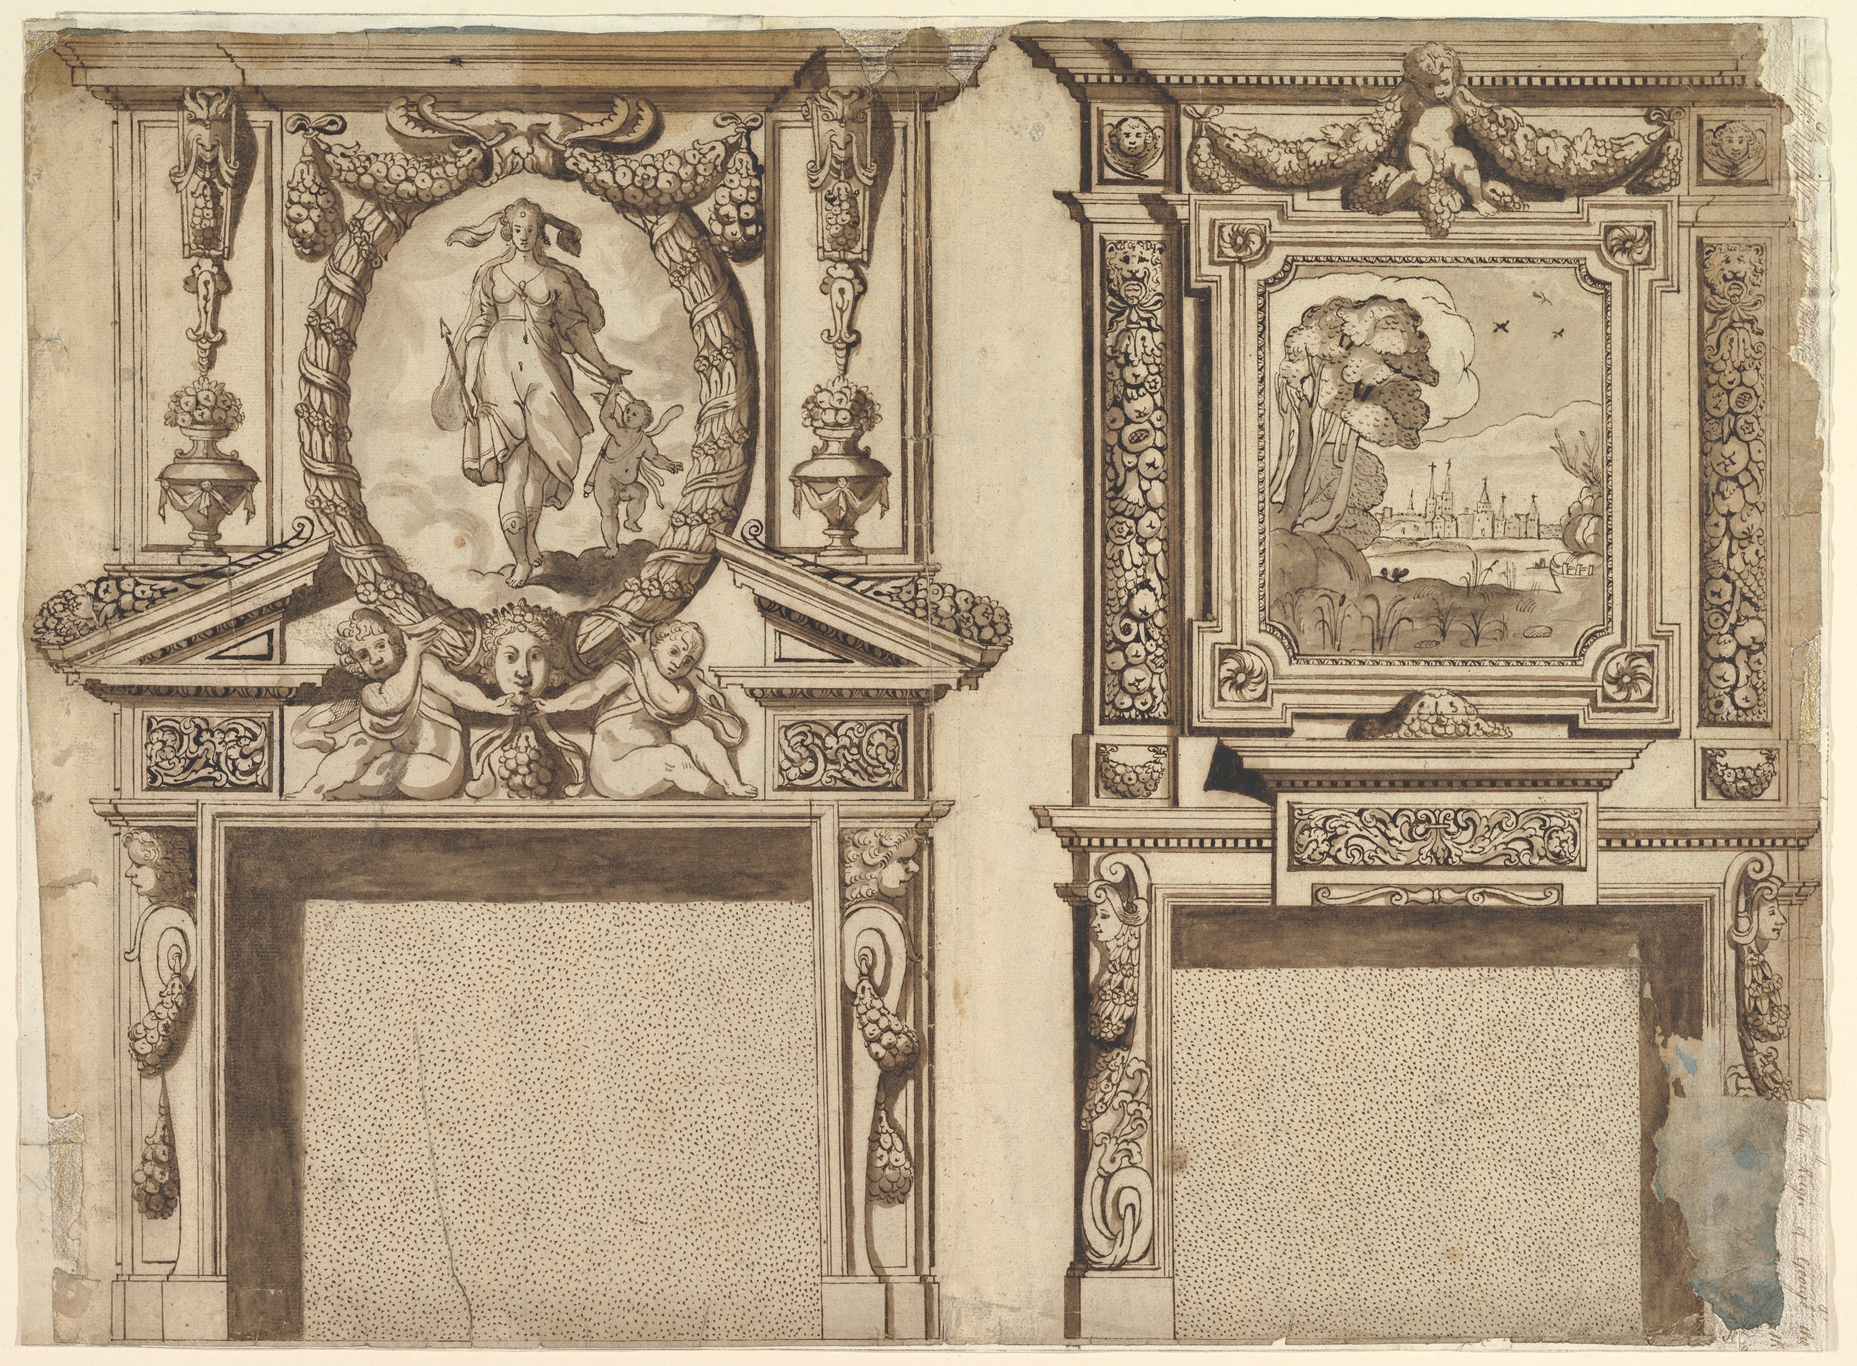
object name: drawing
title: Design for Two Chimneypieces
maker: anonymous, british, 17th century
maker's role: artist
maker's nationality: british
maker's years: 1600-1700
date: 1660-1675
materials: ink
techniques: brush, pen, wash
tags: women,cupid